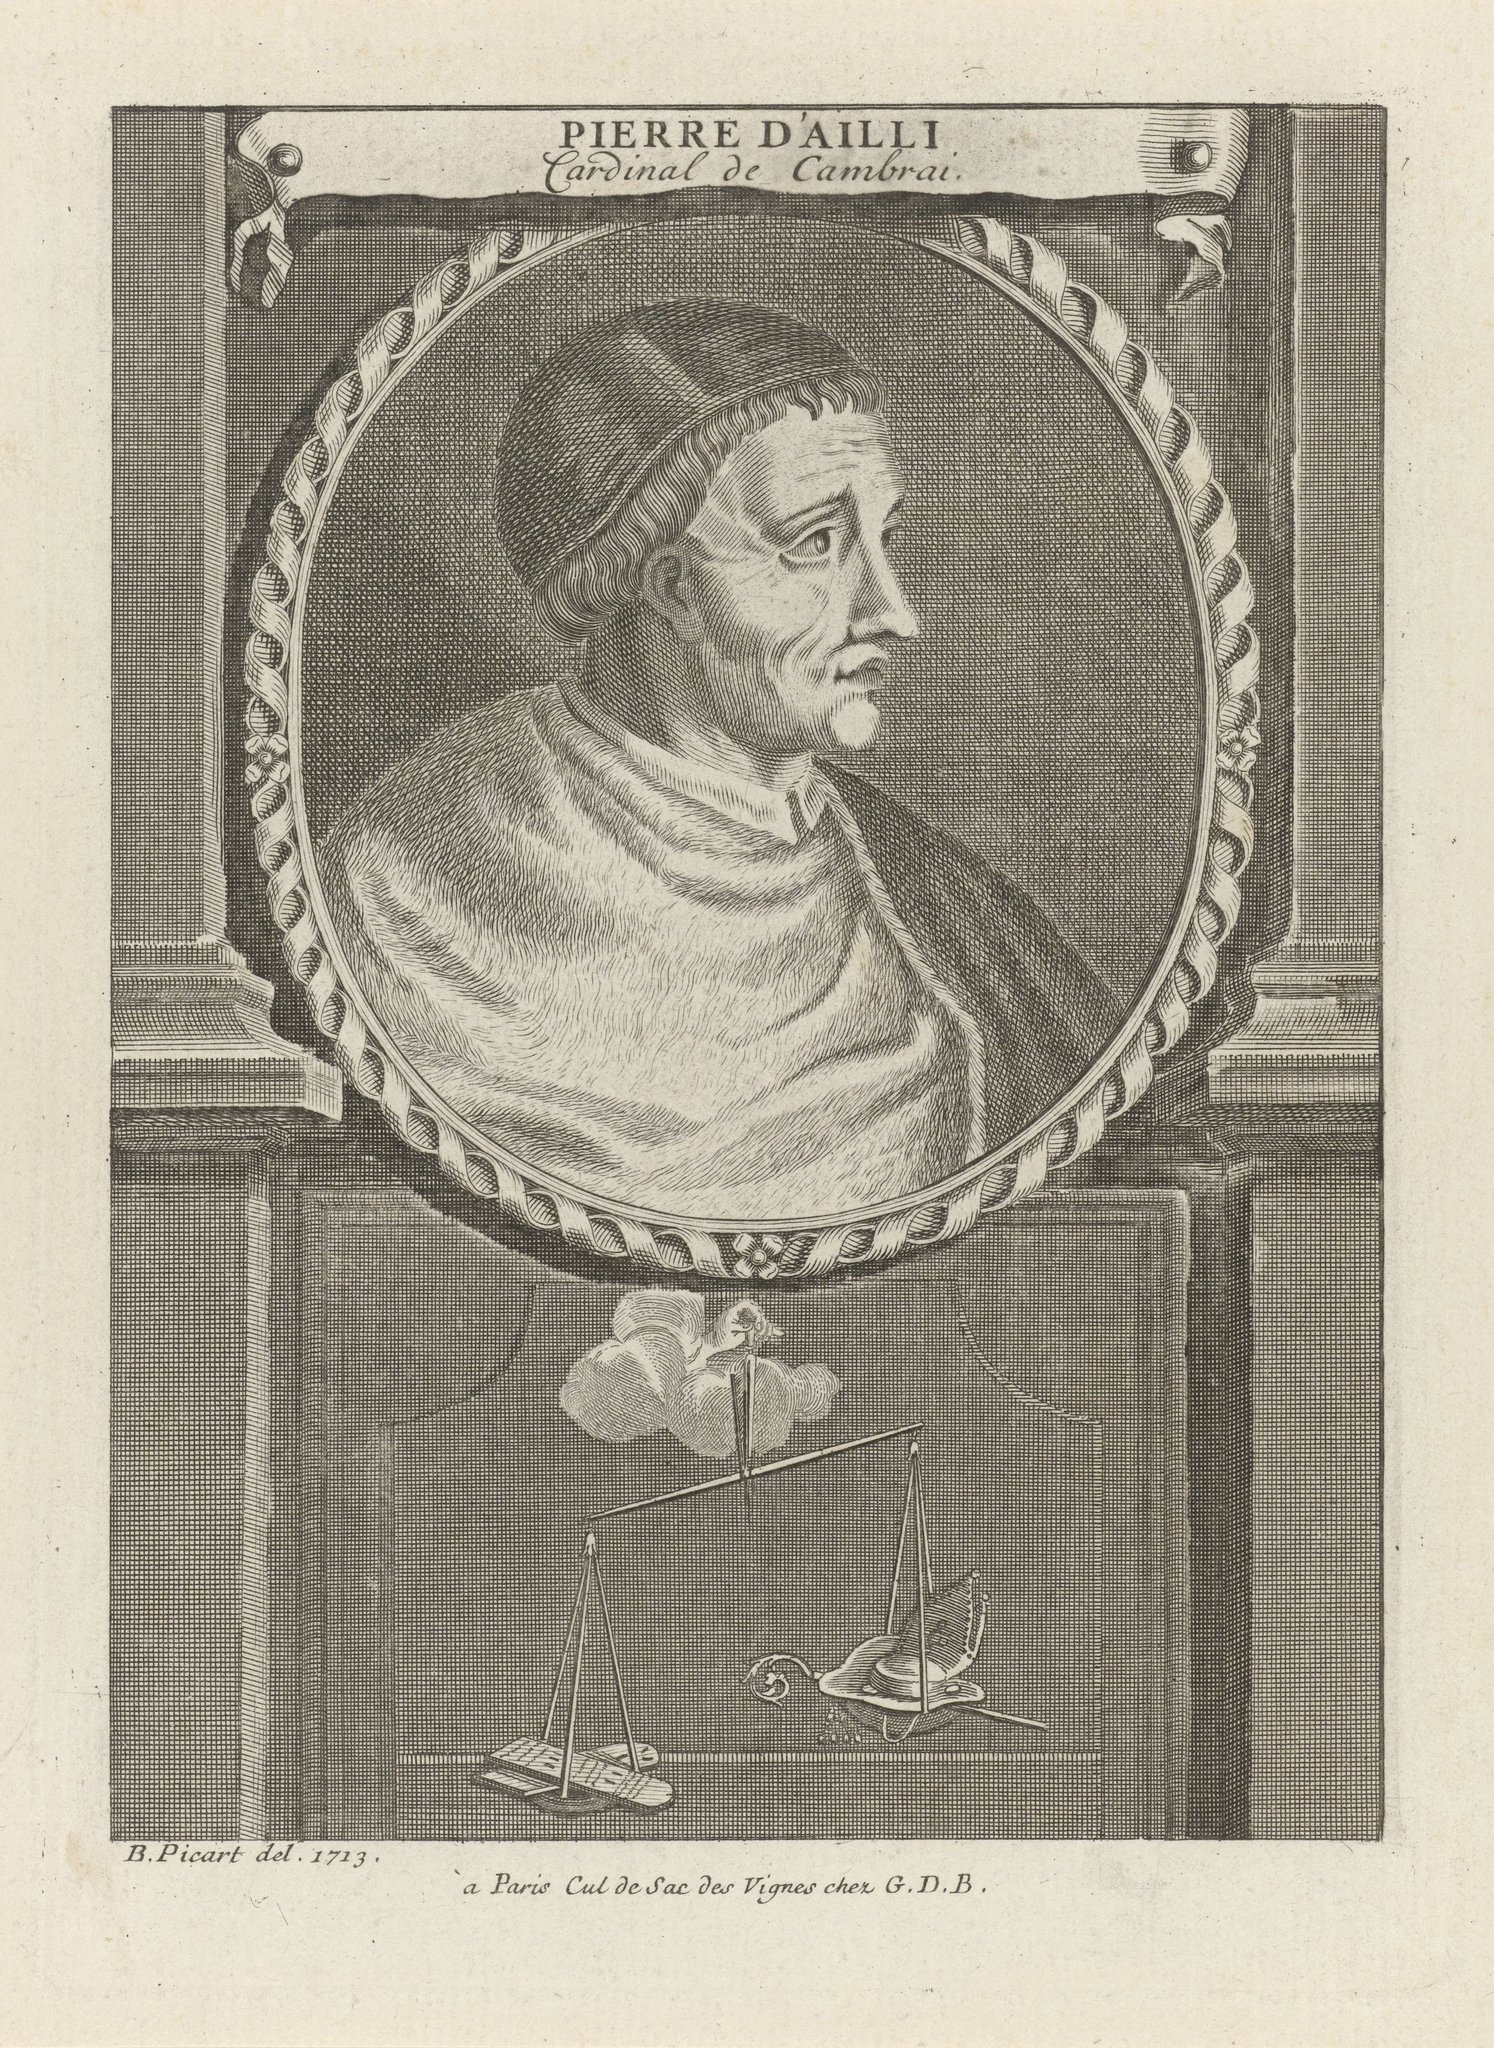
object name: print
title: Portret van Pierre d'Ailly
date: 1713-1763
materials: paper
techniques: engraving, etching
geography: paris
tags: cardinal, scales, insignia of cardinal, e.g. hat, mantle, the new tables of the law (exodus 34)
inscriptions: collector's mark: Lugt 2228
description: Portret van Pierre d'Ailly, Frans theoloog en kardinaal van Kamerijk (Cambrai). Onder de omlijsting een weegschaal waarop aan de ene kant de tafelen der wet en aan de andere kant de attributen van een kardinaal en bisschop.